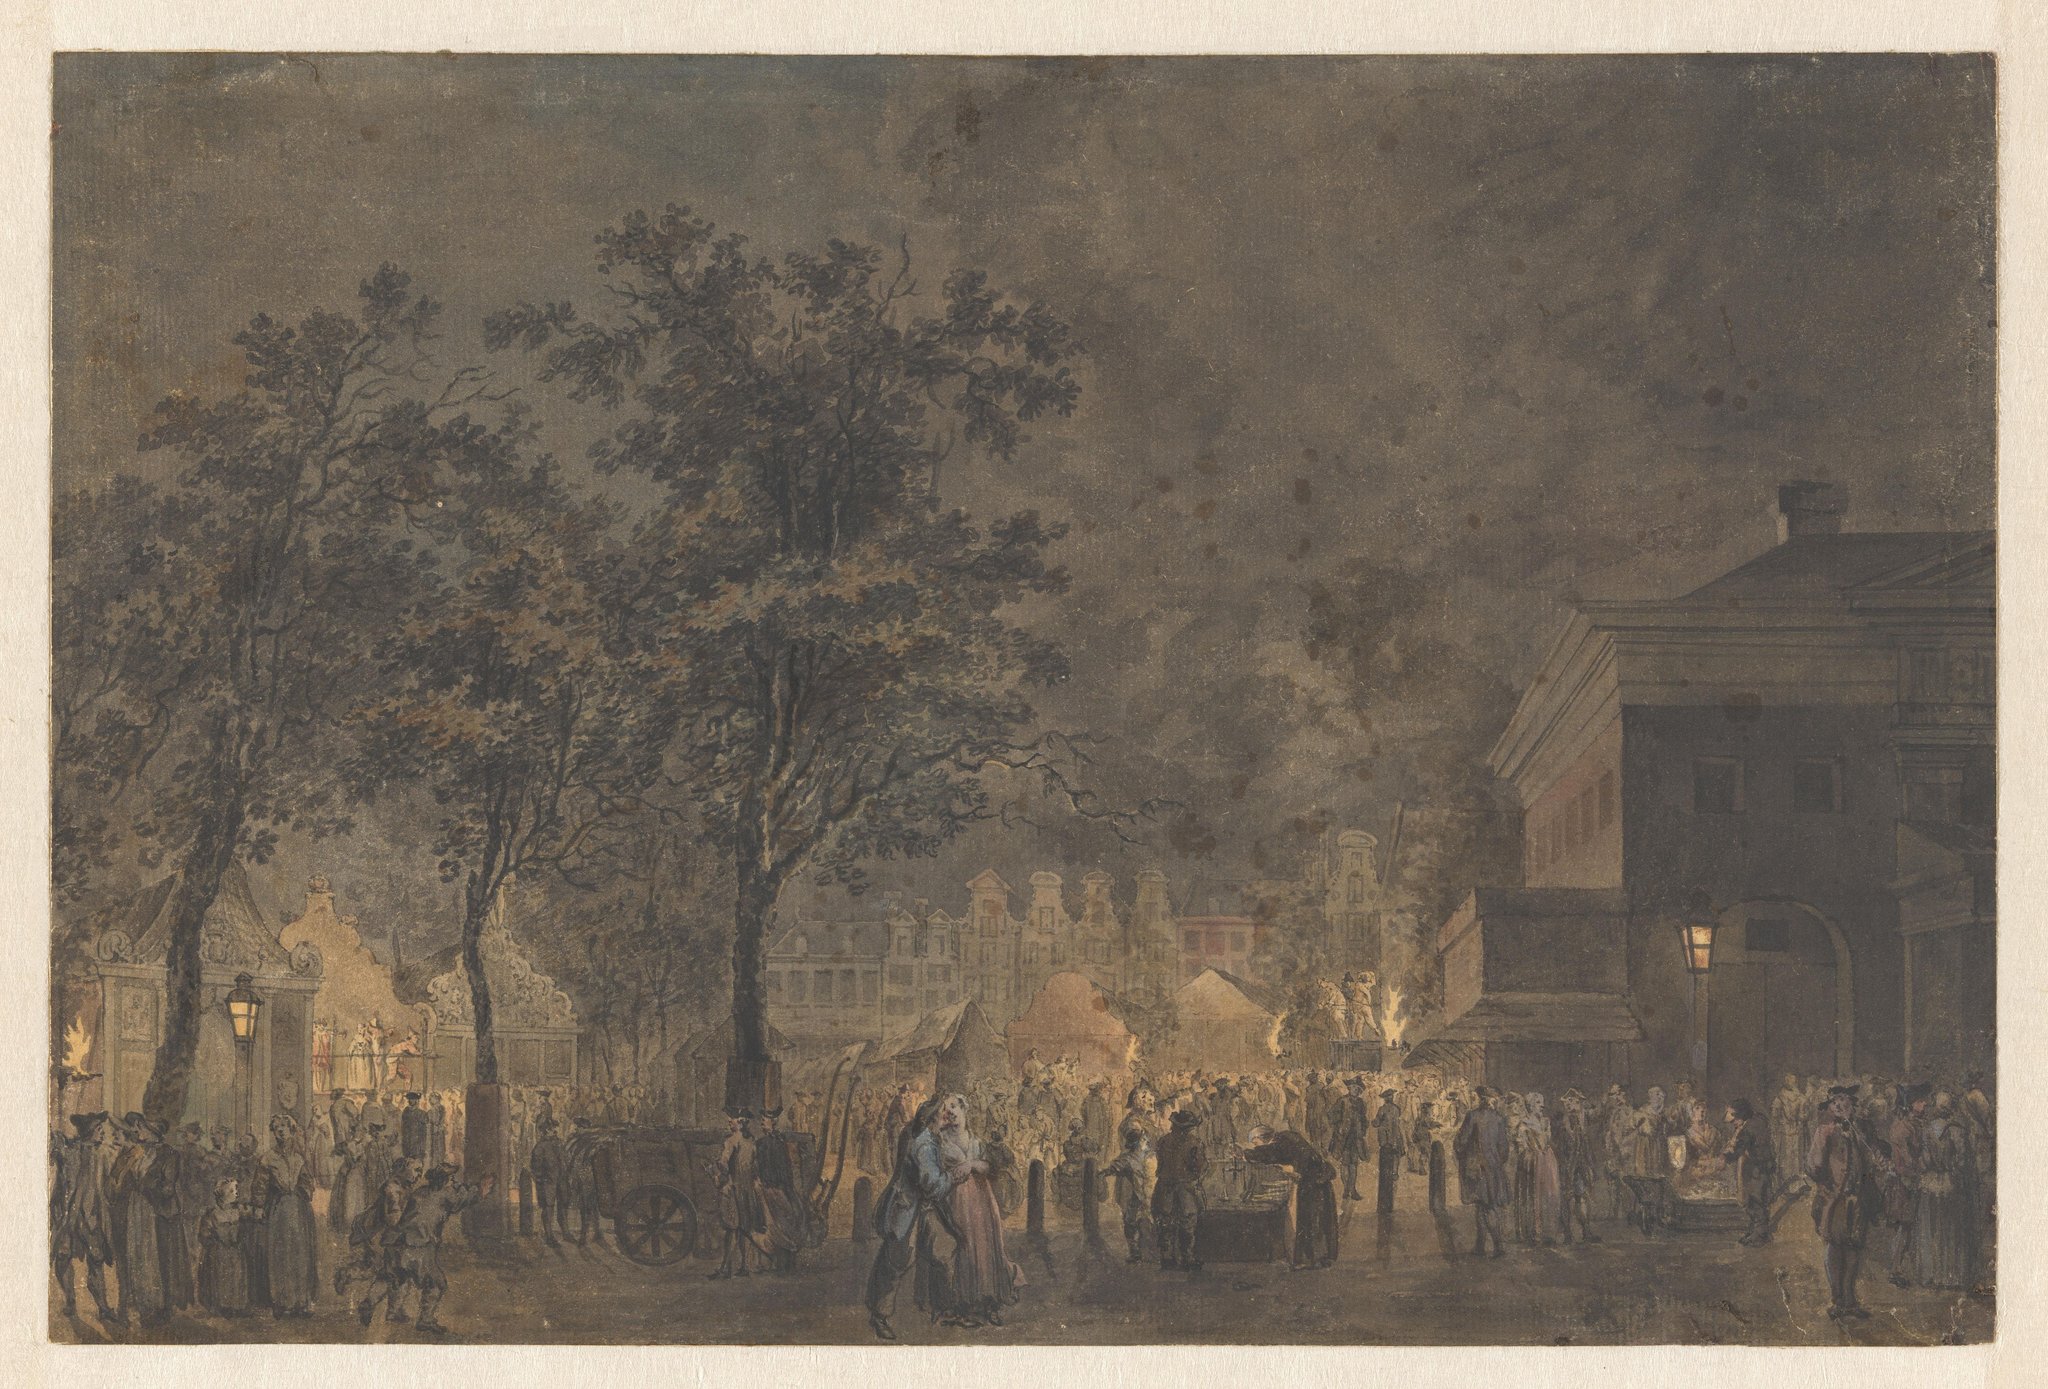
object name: drawing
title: Kermis op de Botermarkt te Amsterdam, het huidige Rembrandtplein, bij avond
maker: simon fokke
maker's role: draughtsman, print maker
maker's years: 1712-1784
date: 1722-1784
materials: ink, paper, watercolor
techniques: brush, pen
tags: botermarkt (amsterdam)